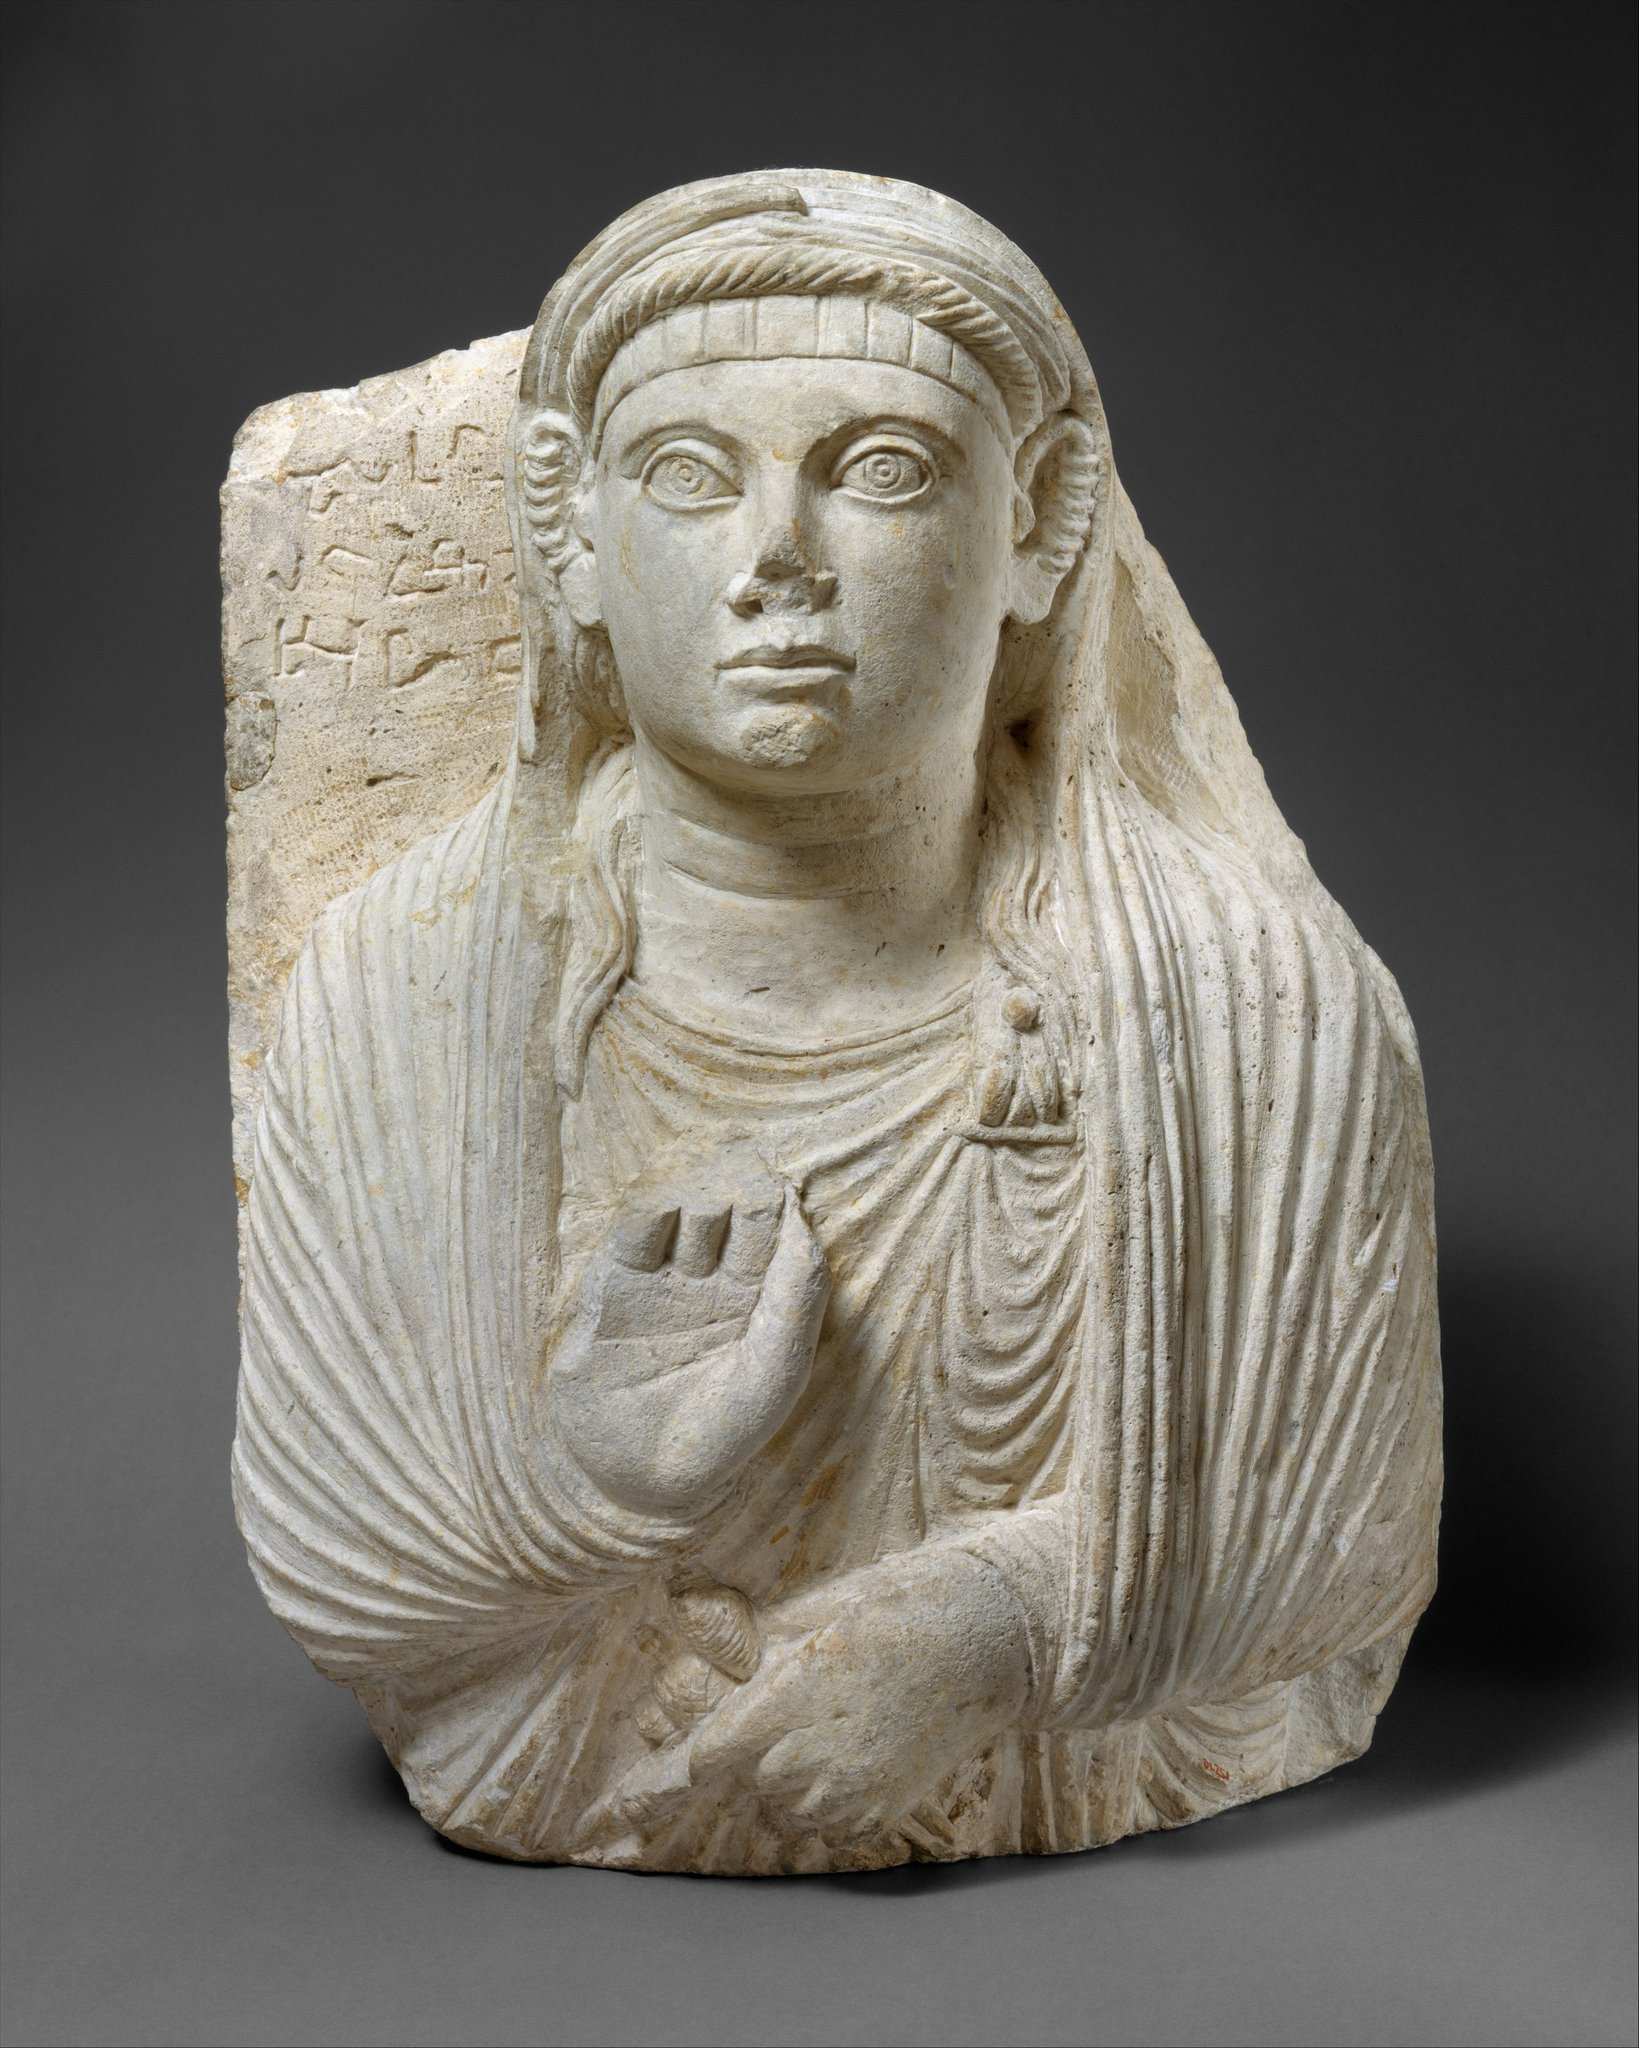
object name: funerary relief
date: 50-150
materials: limestone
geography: syria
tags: women